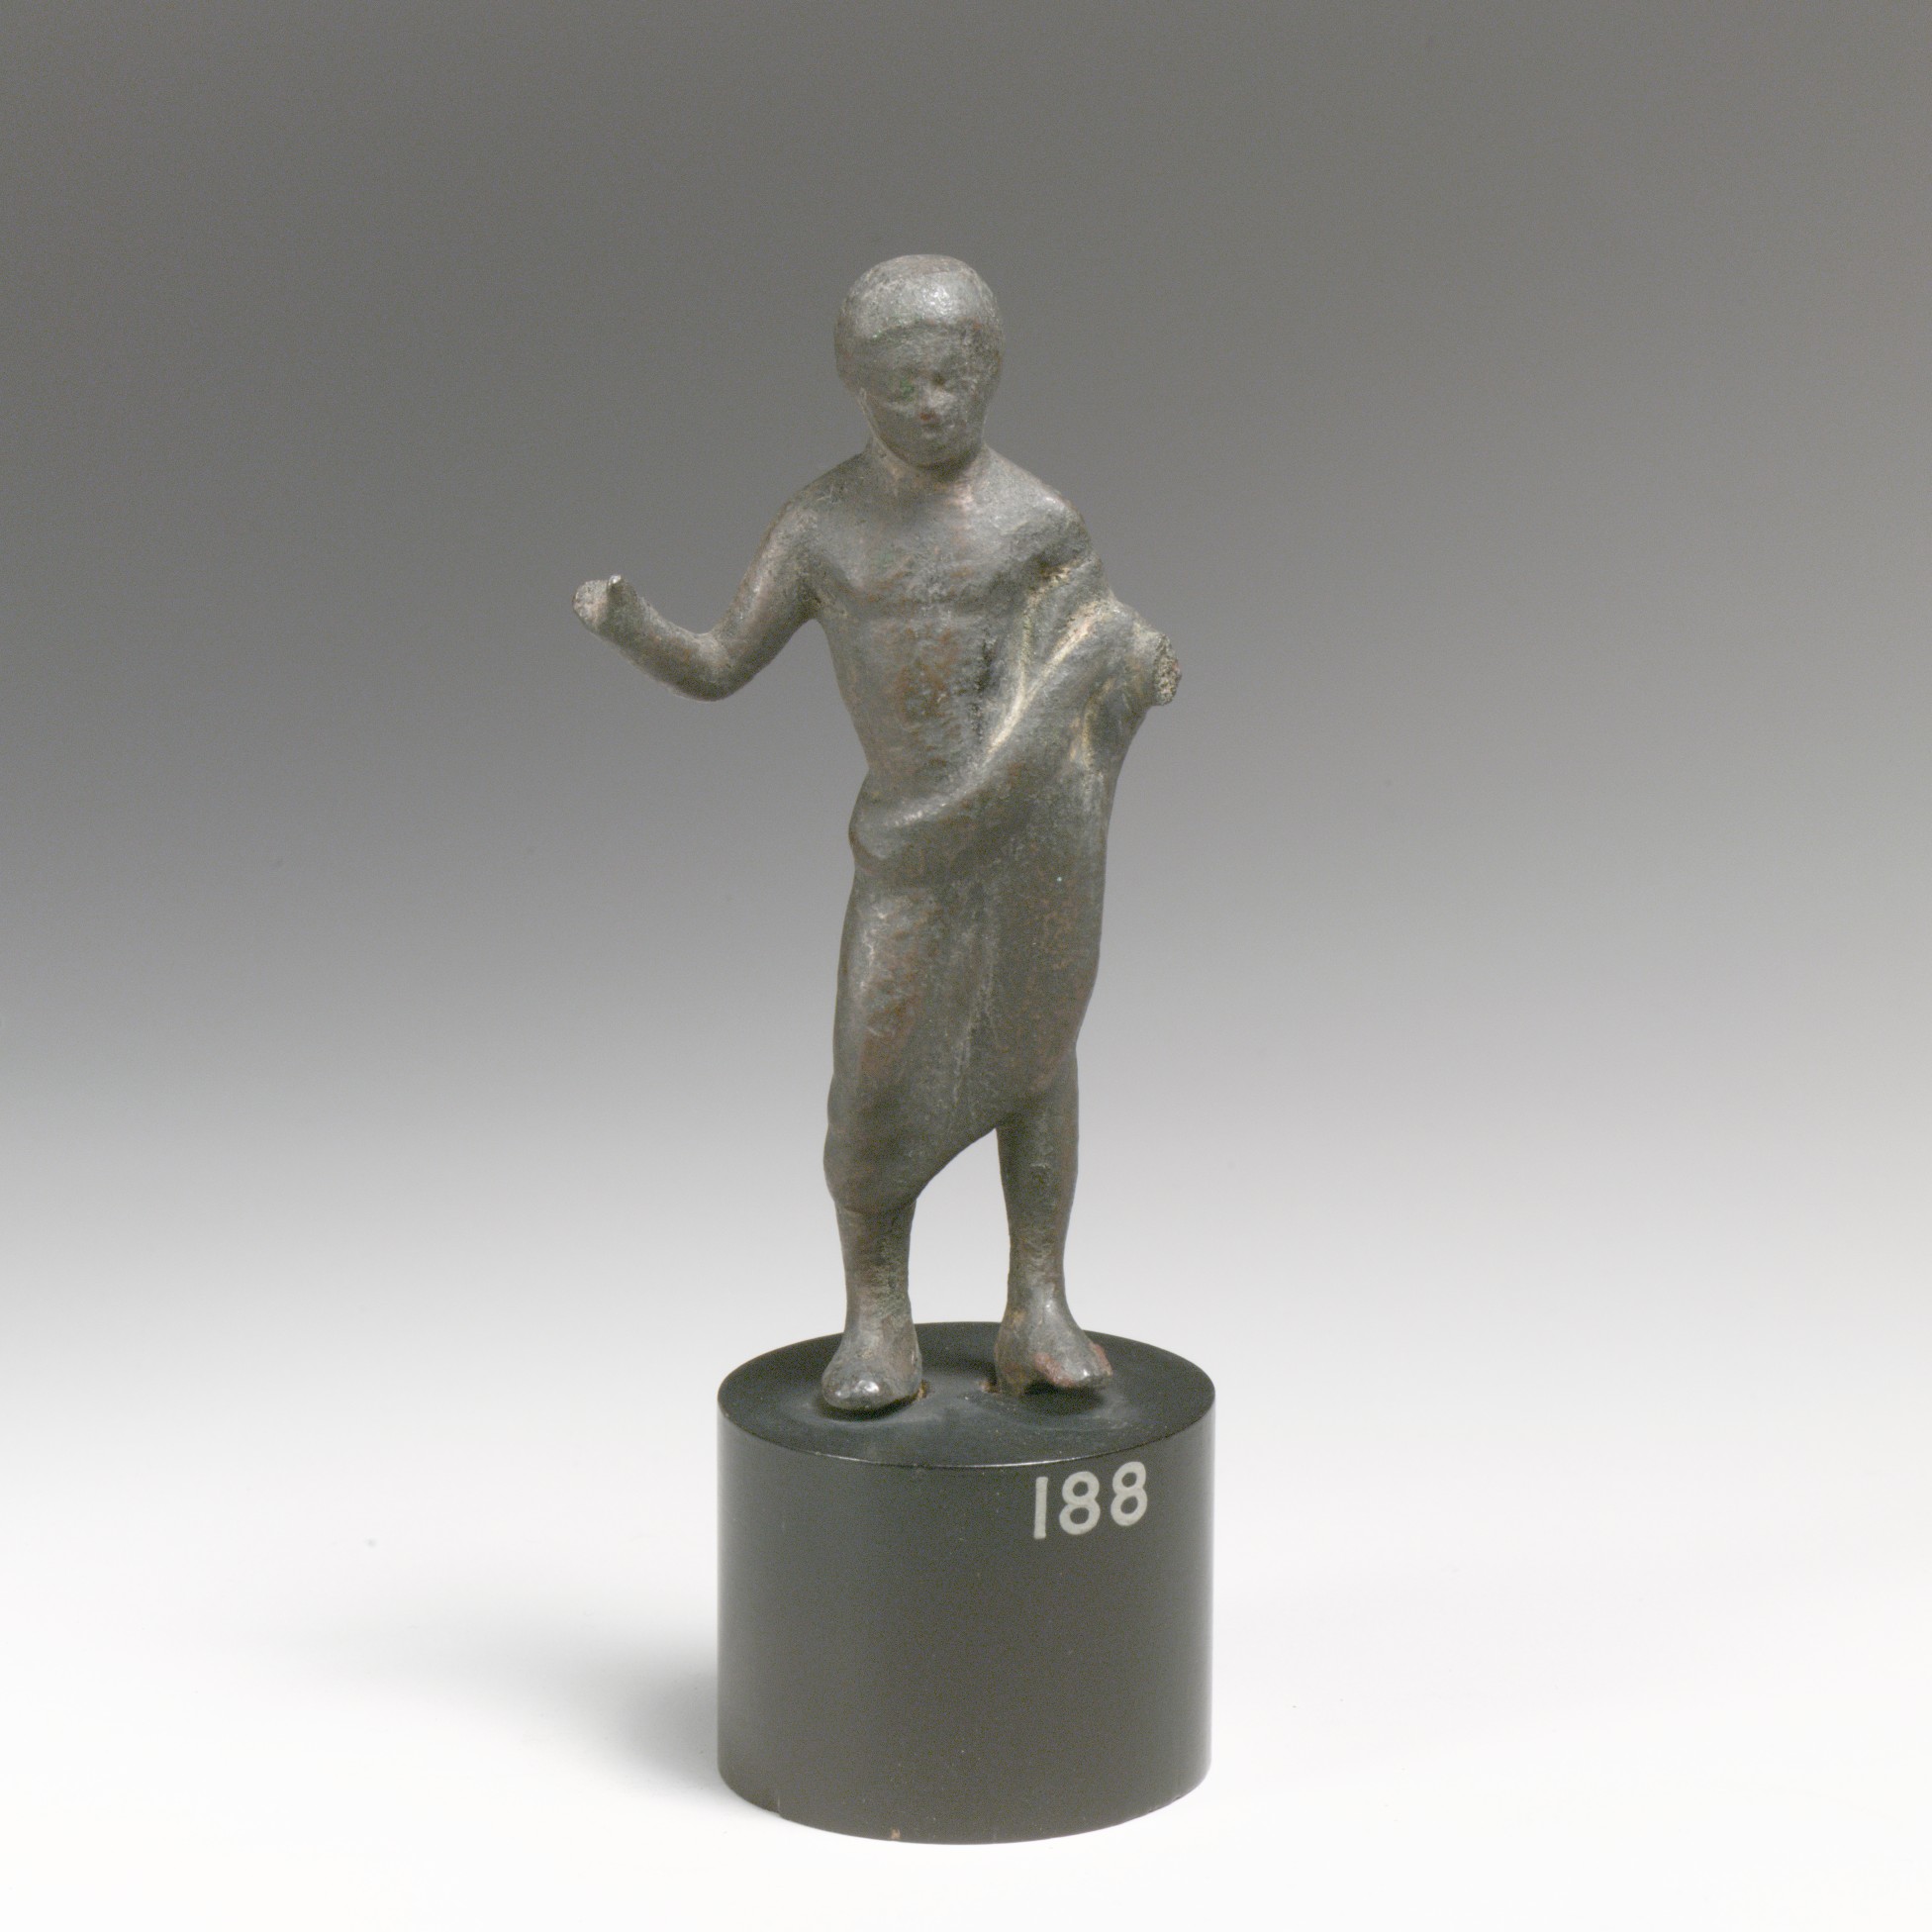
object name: statuette of a man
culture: etruscan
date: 400-1 BCE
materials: bronze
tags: men